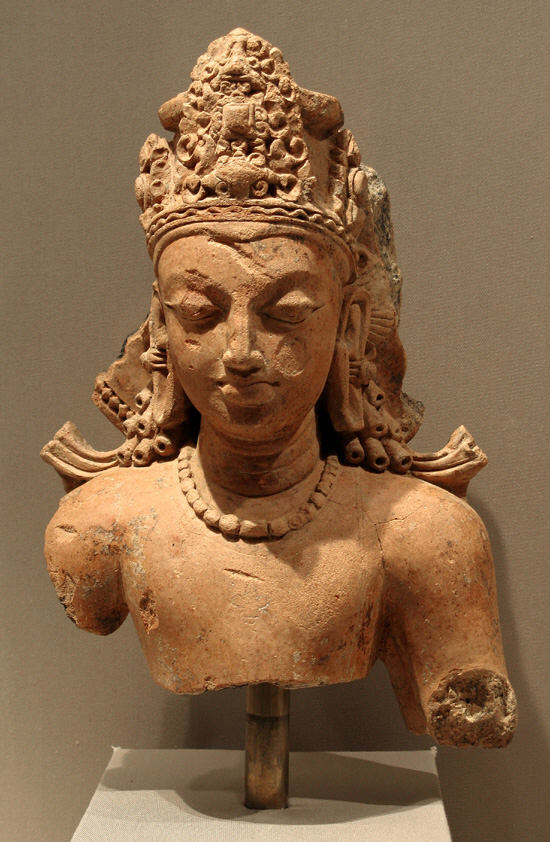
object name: bust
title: Bust of Vishnu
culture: indian, bengal or bangladesh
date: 401-600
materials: terracotta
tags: gupta,vishnu,hinduism